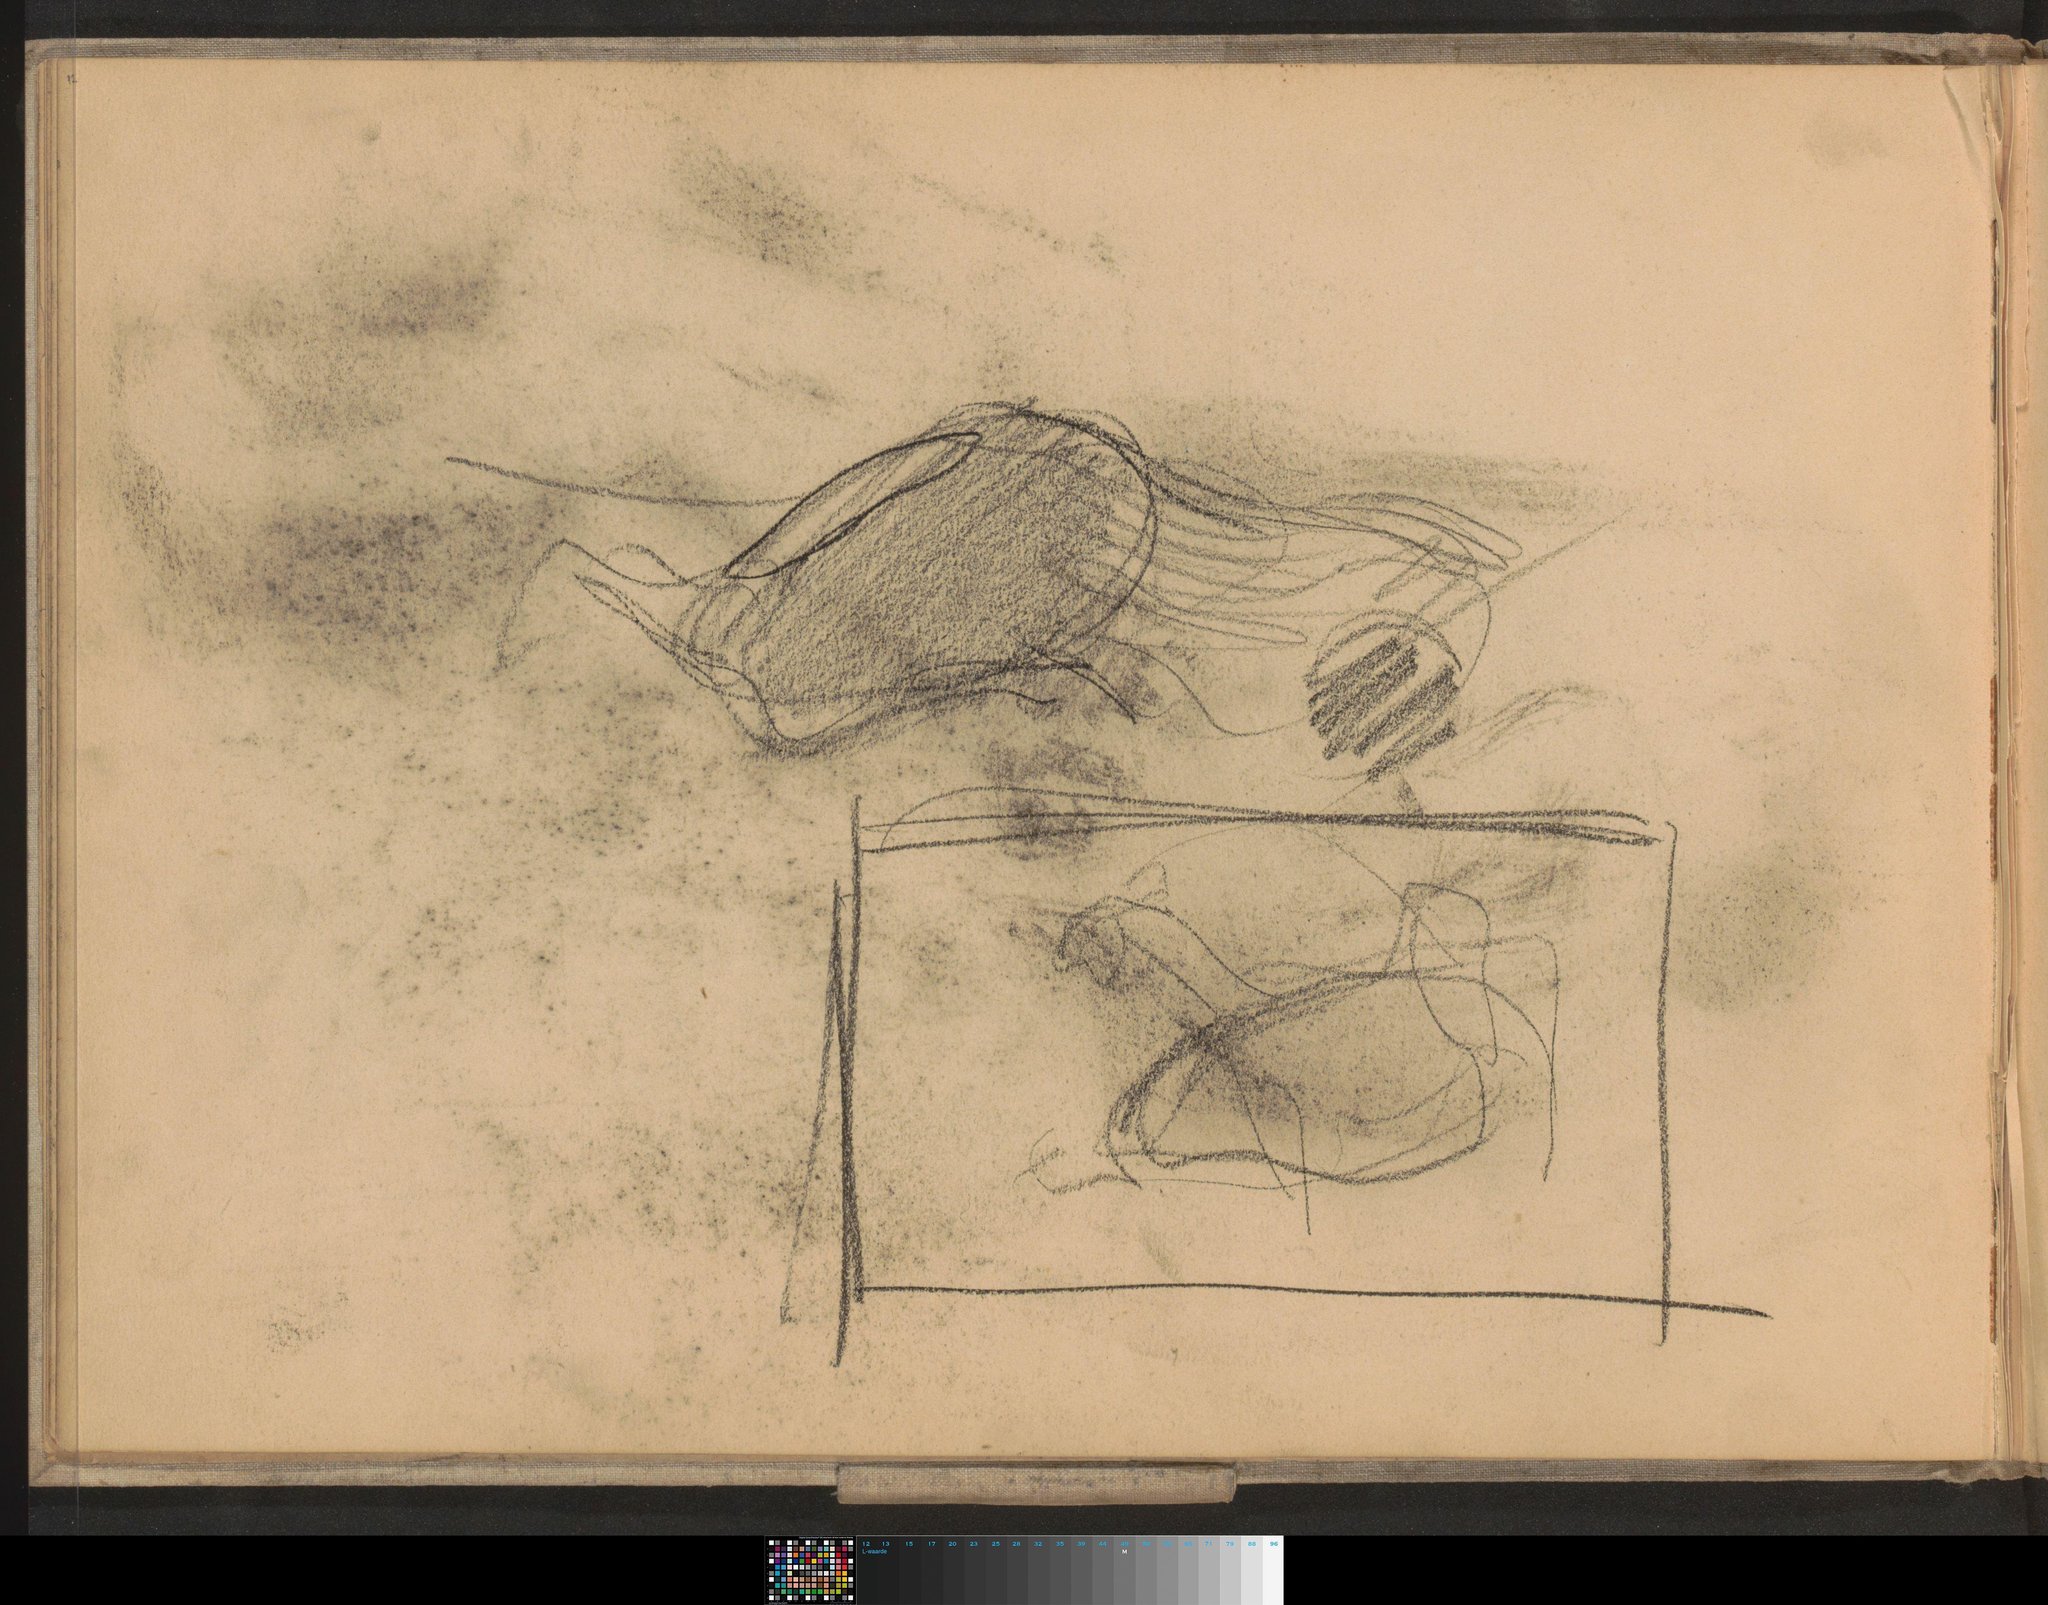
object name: sketchbook leaf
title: Studies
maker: marius bauer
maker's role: draughtsman, print maker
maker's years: 1867-1932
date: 1887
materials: chalk, paper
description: Pagina 12 uit een schetsboek met 19 bladen.